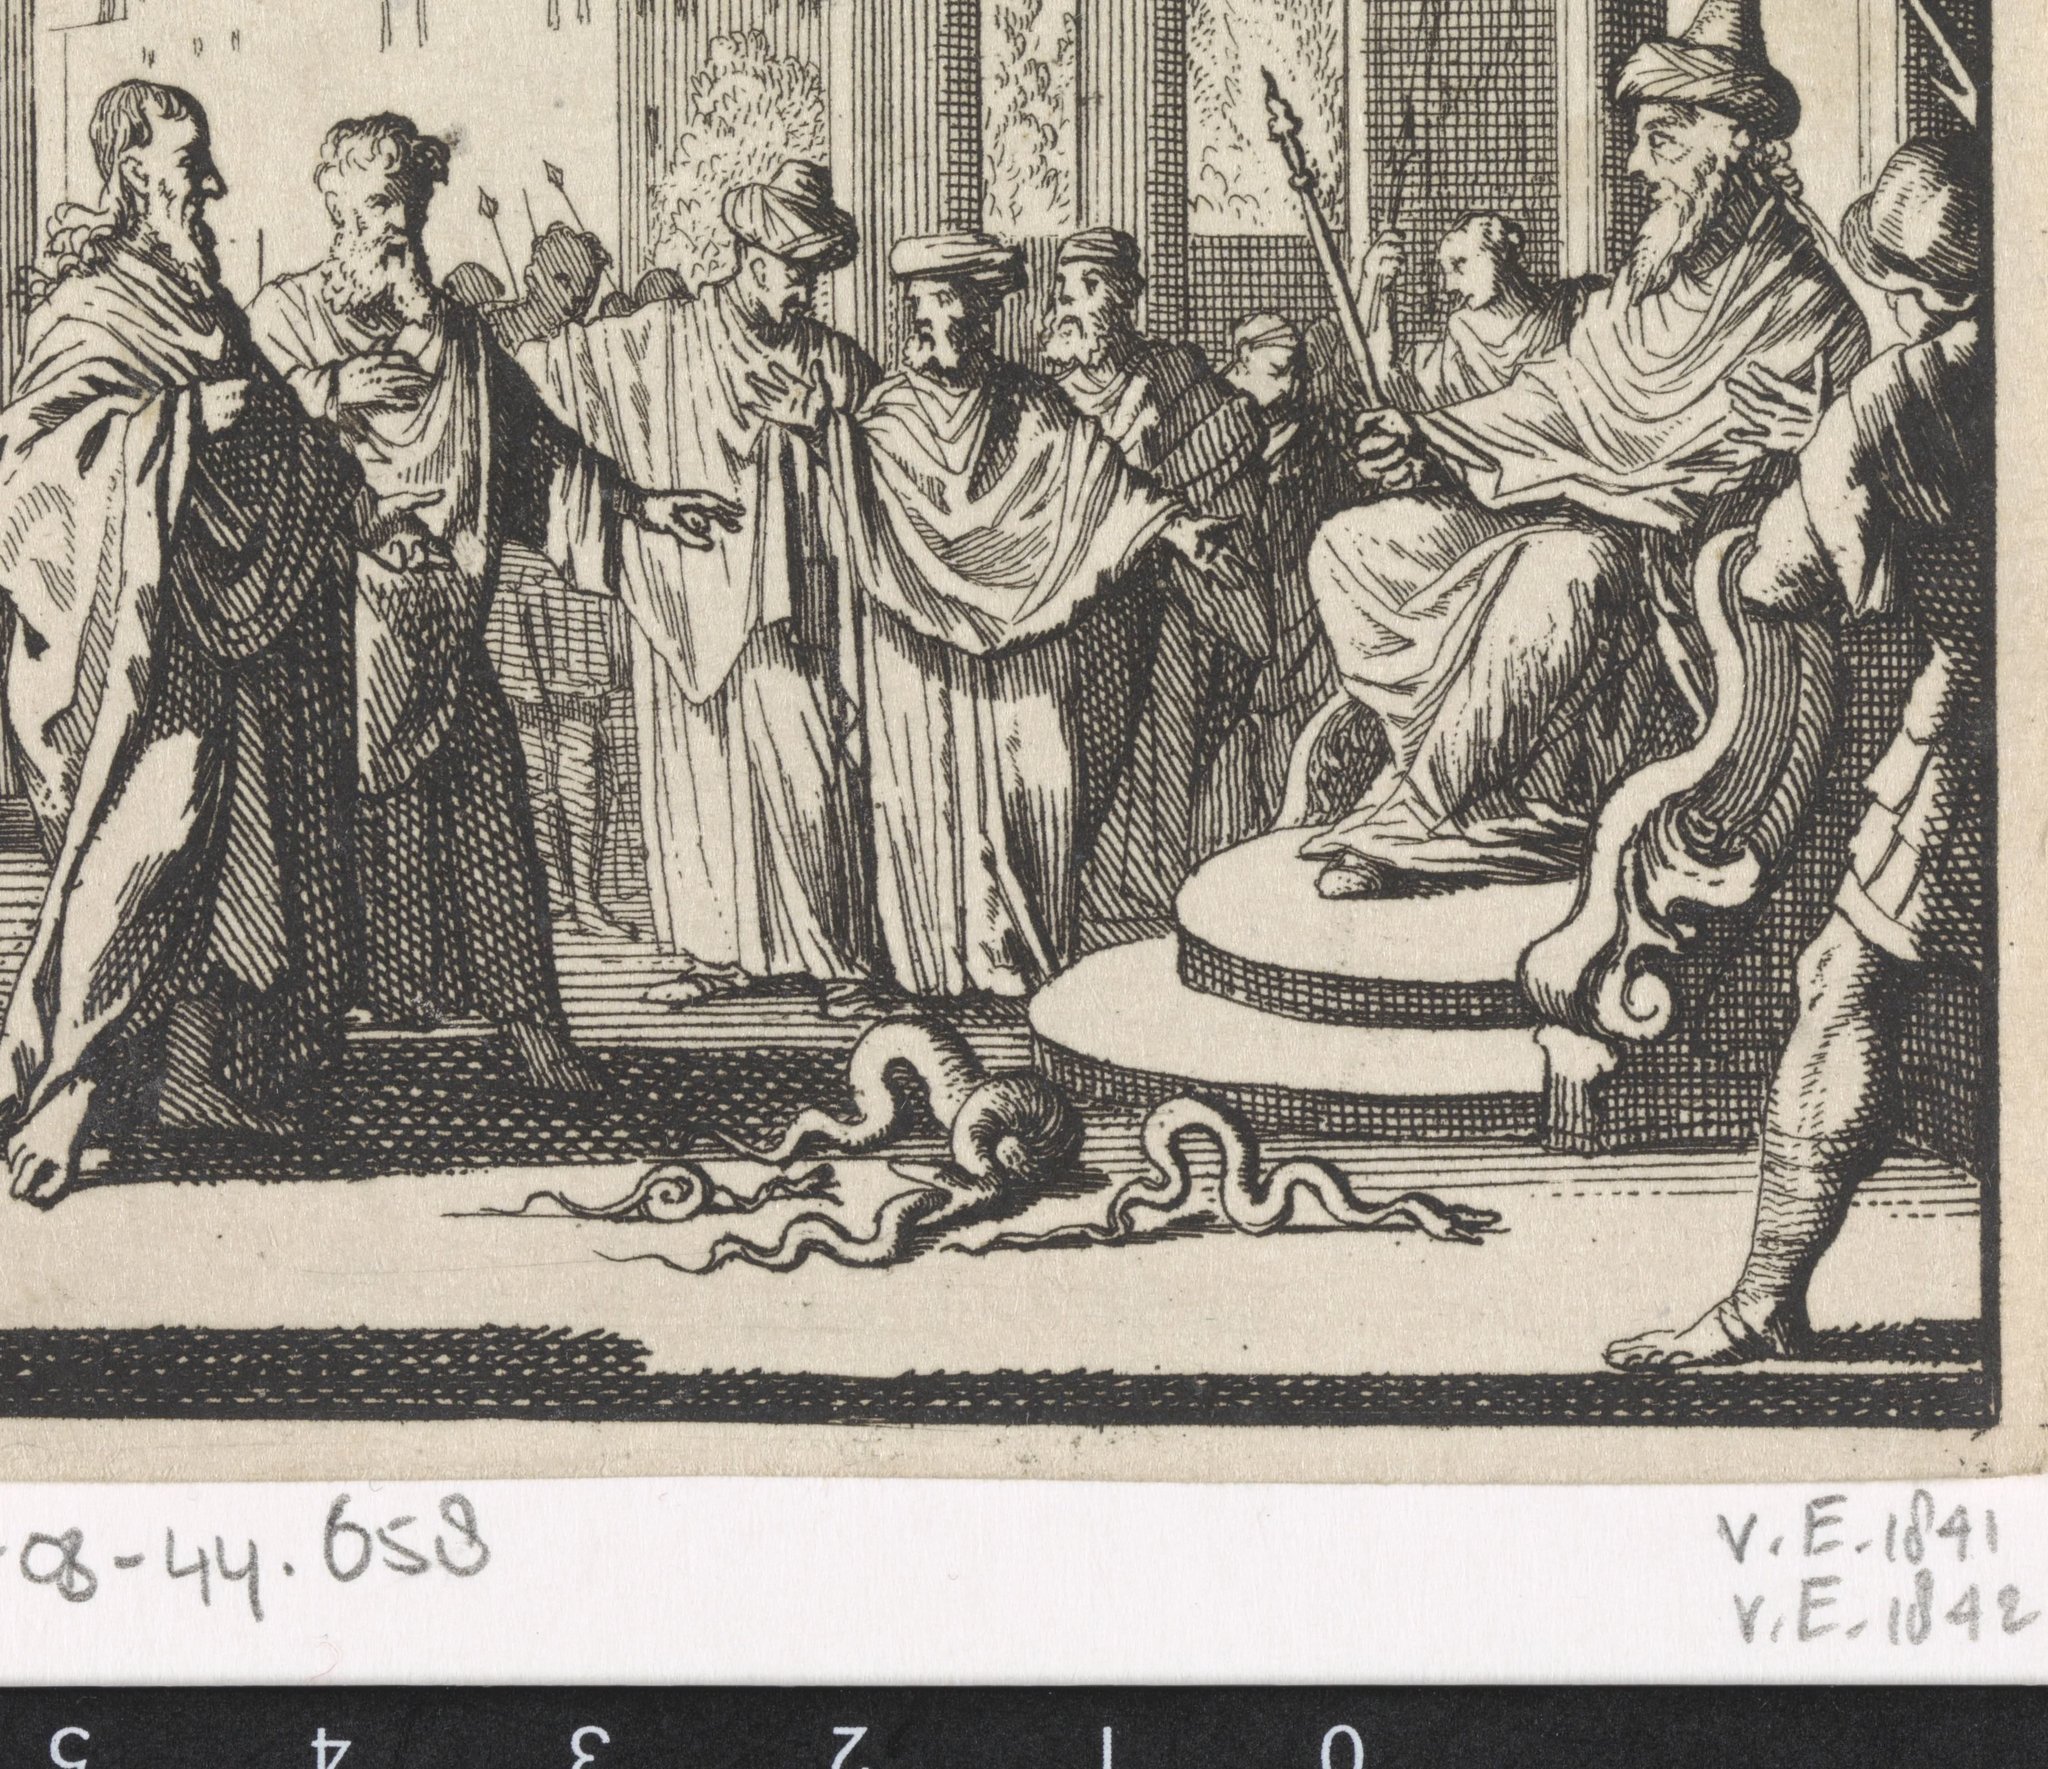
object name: print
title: Mozes en Aaron voor de farao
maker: caspar luyken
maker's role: draughtsman, print maker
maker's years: 1672-1708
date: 1698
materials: paper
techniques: etching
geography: amsterdam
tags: moses and aaron confront pharaoh (exodus 5-7:13)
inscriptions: collector's mark: Lugt 2228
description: Proefdruk van illustratie uit: Josephus, Flavius. XX. boeken van de oude geschiedenissen der joden, 4 delen. Amsterdam: Barent Visscher, Willem de Coup, Willem van Lamsveld, Andries van Damme, 1698, dl. I.